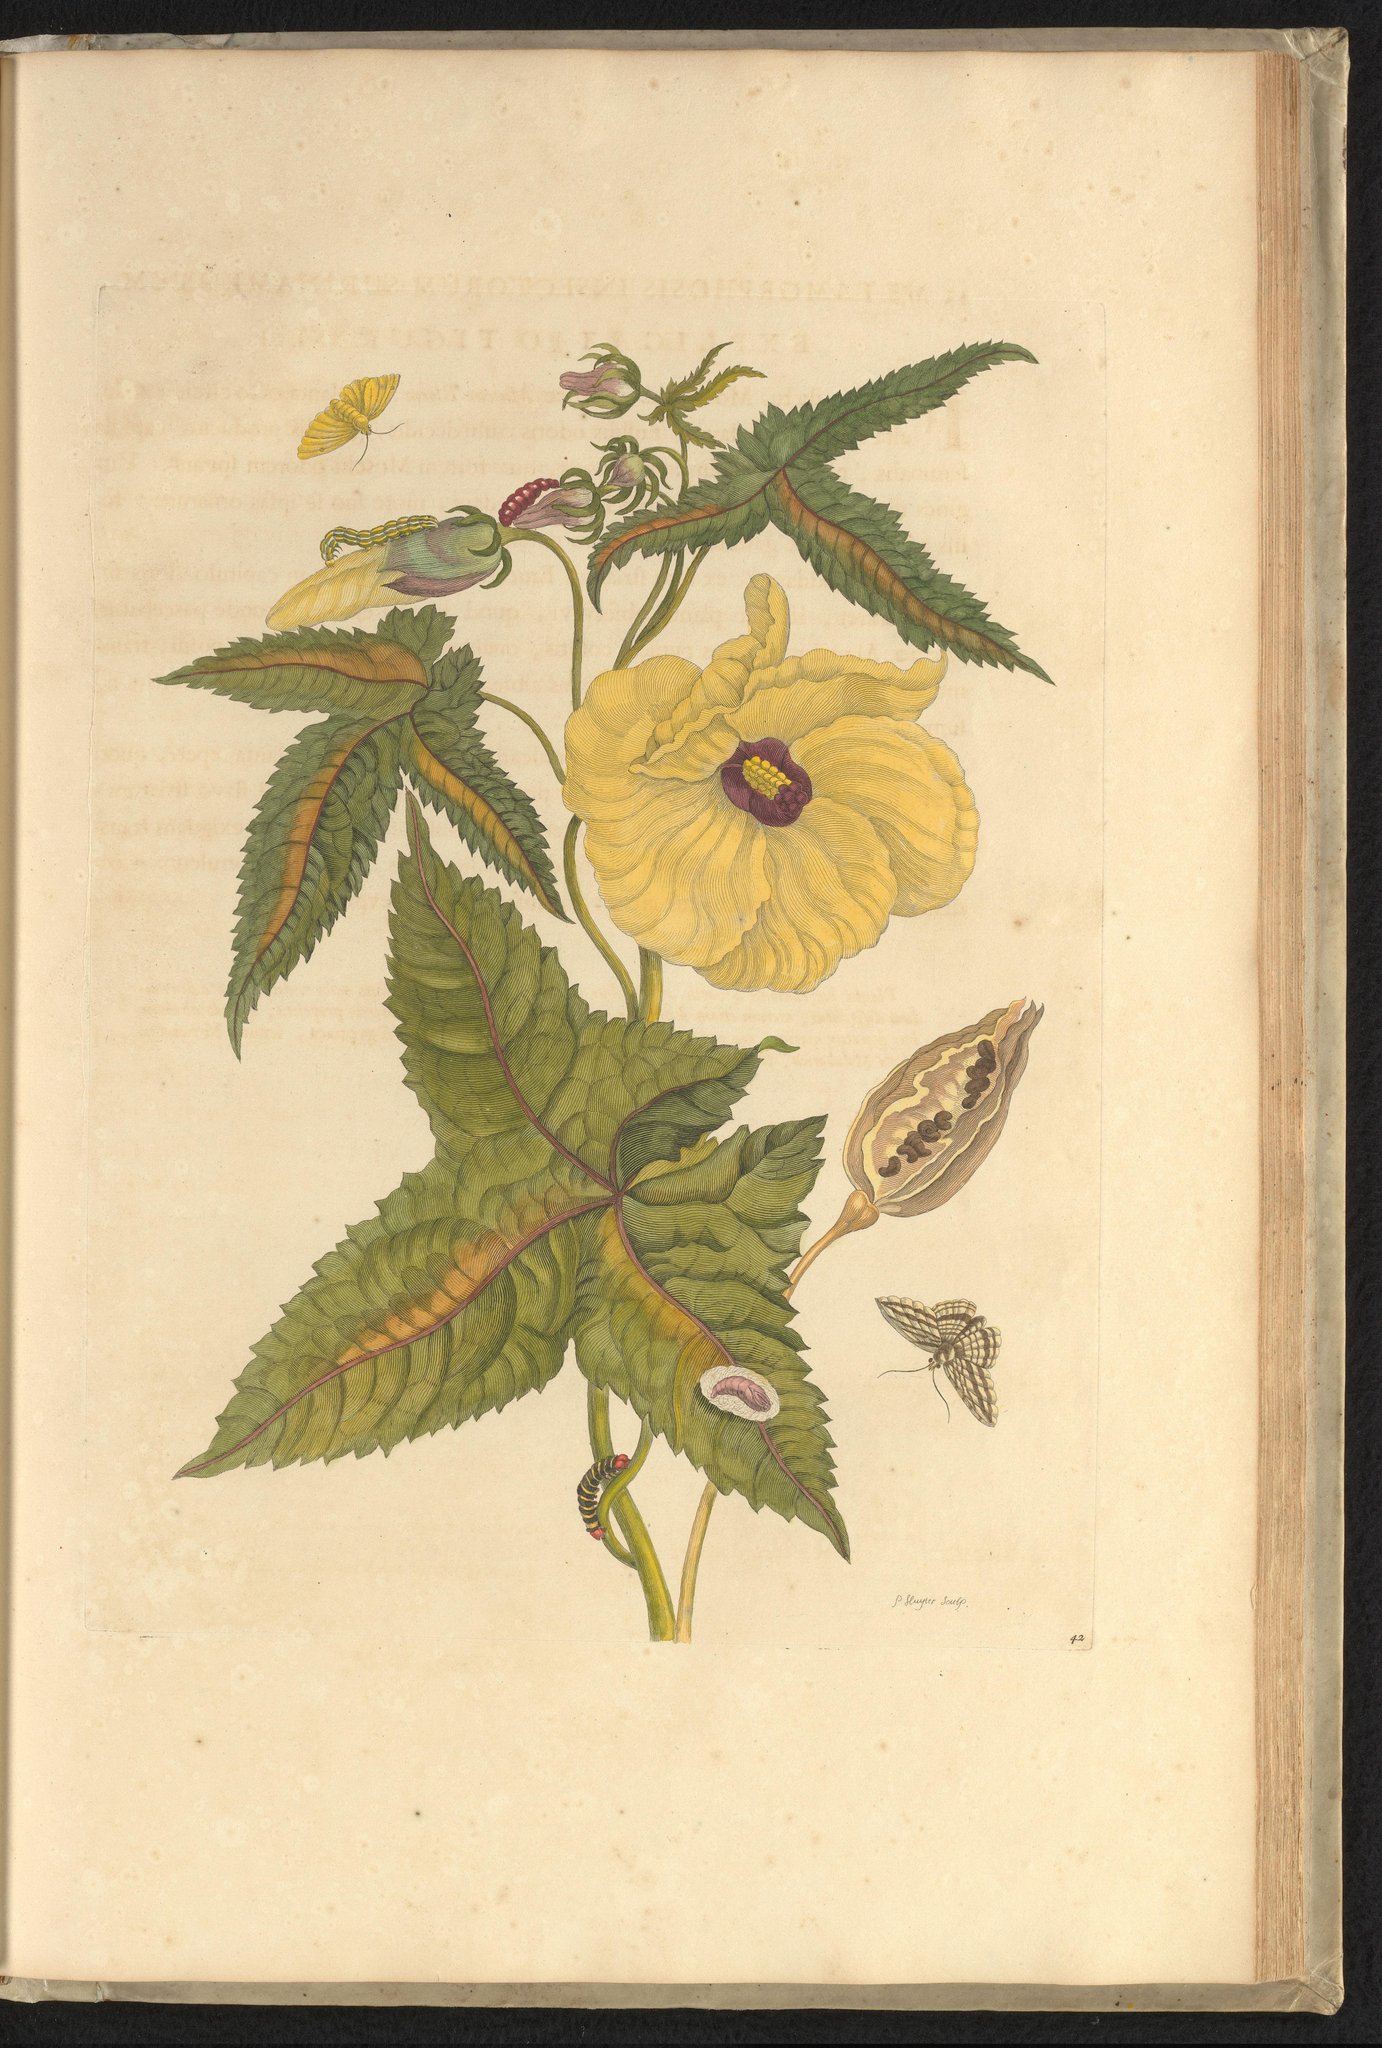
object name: print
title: Wilde oker (Abelmoschus moschatus) met nachtvlinders, rupsen en poppen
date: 1705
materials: paper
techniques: etching, hand coloring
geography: amsterdam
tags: flowers, insects: pupa, insects: moth, insects: caterpillar, suriname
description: Rechtsonder genummerd: 42. Prent maakt deel uit van een boek.